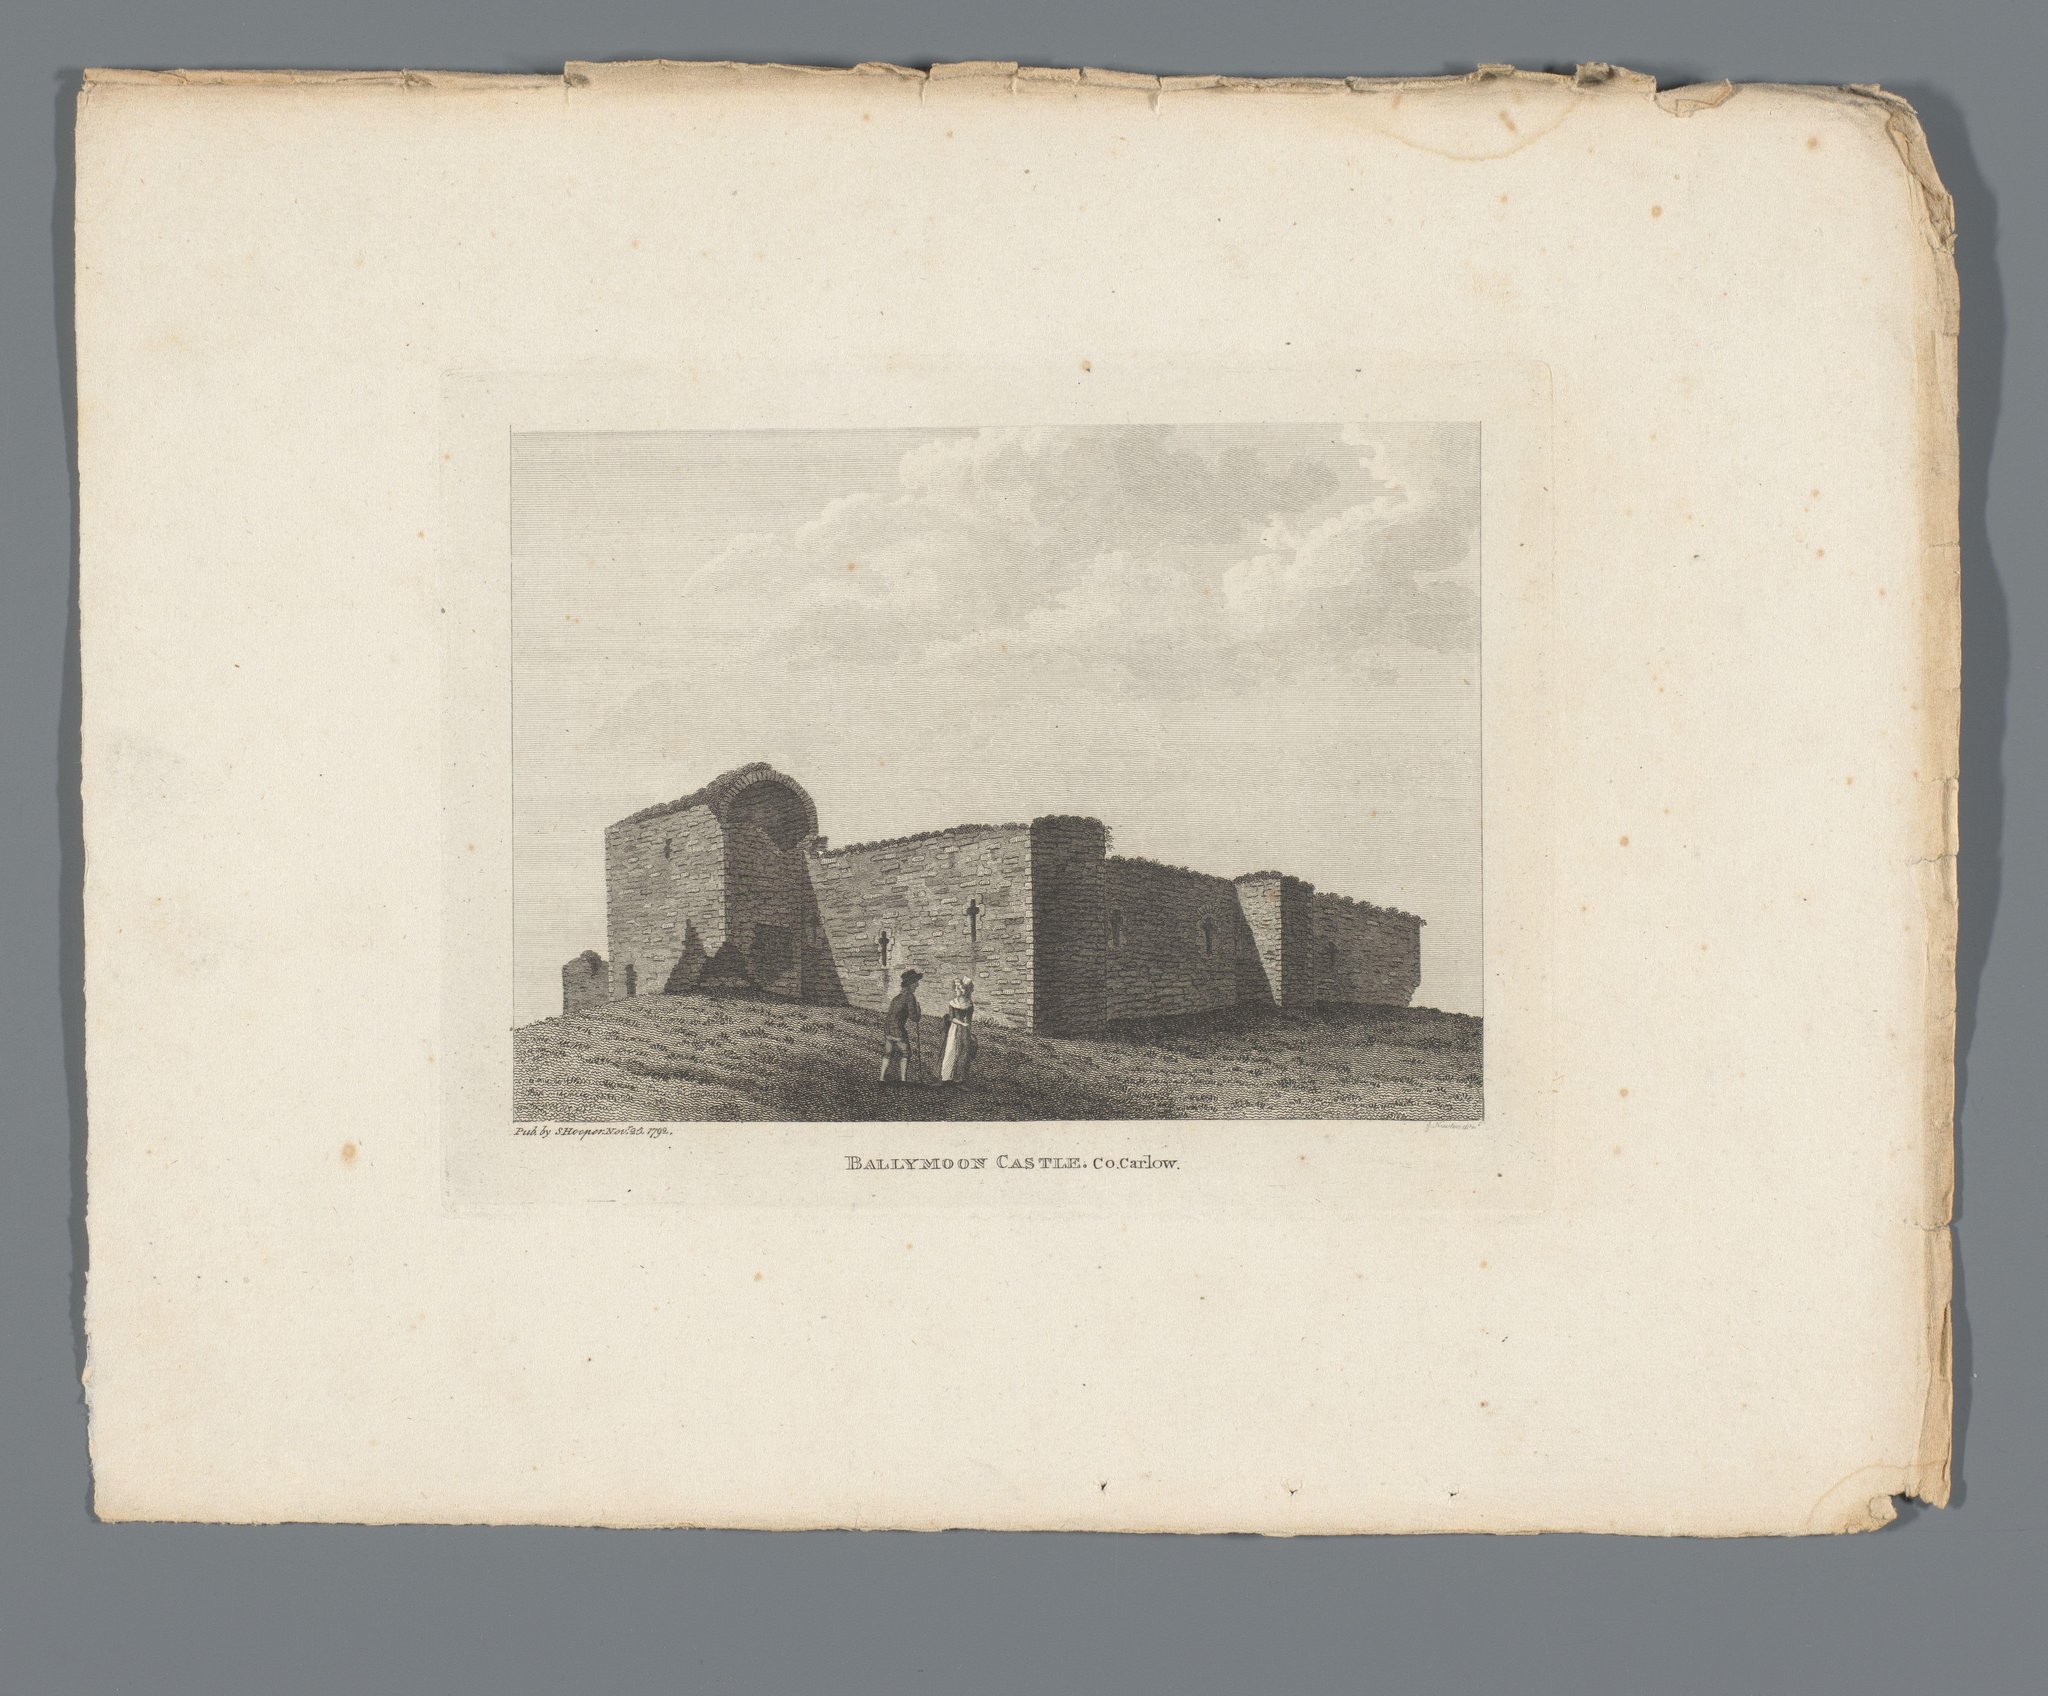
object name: print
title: Ballymoon Castle. Co.Carlow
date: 1792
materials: paper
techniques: etching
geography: london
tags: landscape with ruins, landscape with tower or castle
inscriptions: date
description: Prent verschenen in: Grose, Francis. The antiquities of Ireland, dl. 2. Londen: S. Hooper, 1795.